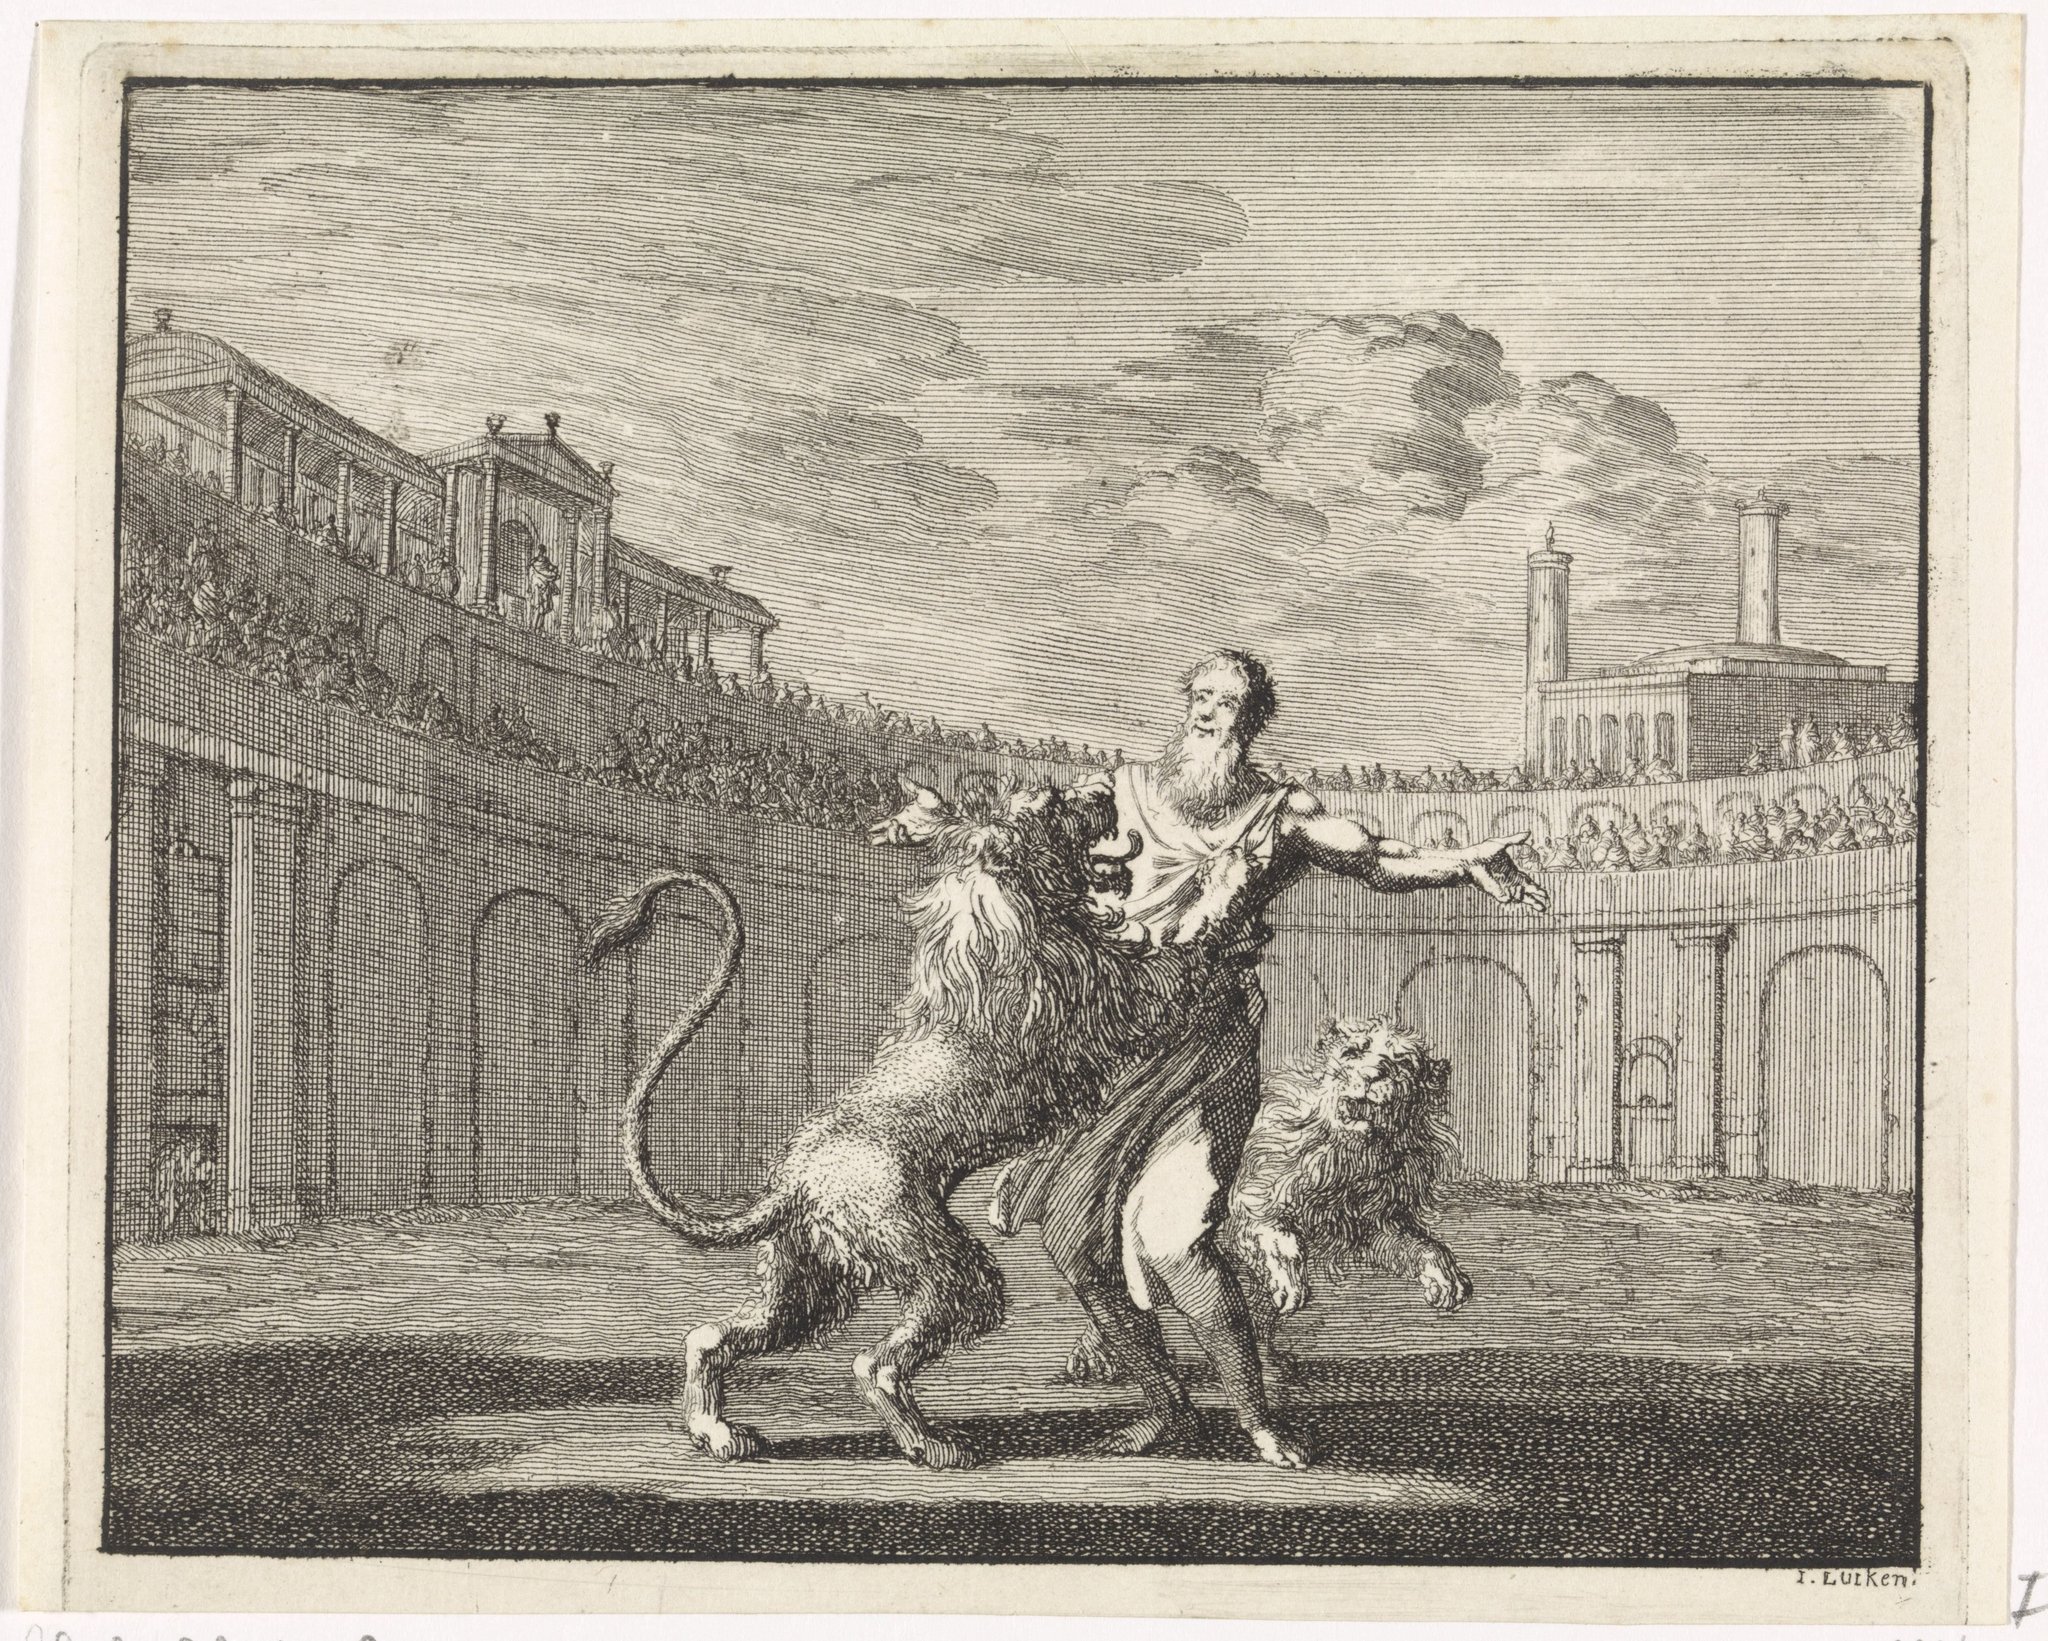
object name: print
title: Ignatius van Antiochië laat zich door leeuwen verscheuren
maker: jan luyken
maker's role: draughtsman, print maker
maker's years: 1649-1712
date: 1701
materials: paper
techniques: etching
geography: amsterdam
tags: the early christian churches, e.g. armenians, copts, syrians, st. ignatius of antioch is thrown to the lions in the arena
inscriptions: collector's mark: Lugt 2228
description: Proefdruk van een boekillustratie Arnold, Godfried. Waare afbeelding der eerste christenen. Amsterdam: Jacobus van Hardenberg, Barent Visscher en Jacobus van Nieuweveen, 1700, dl. 2.